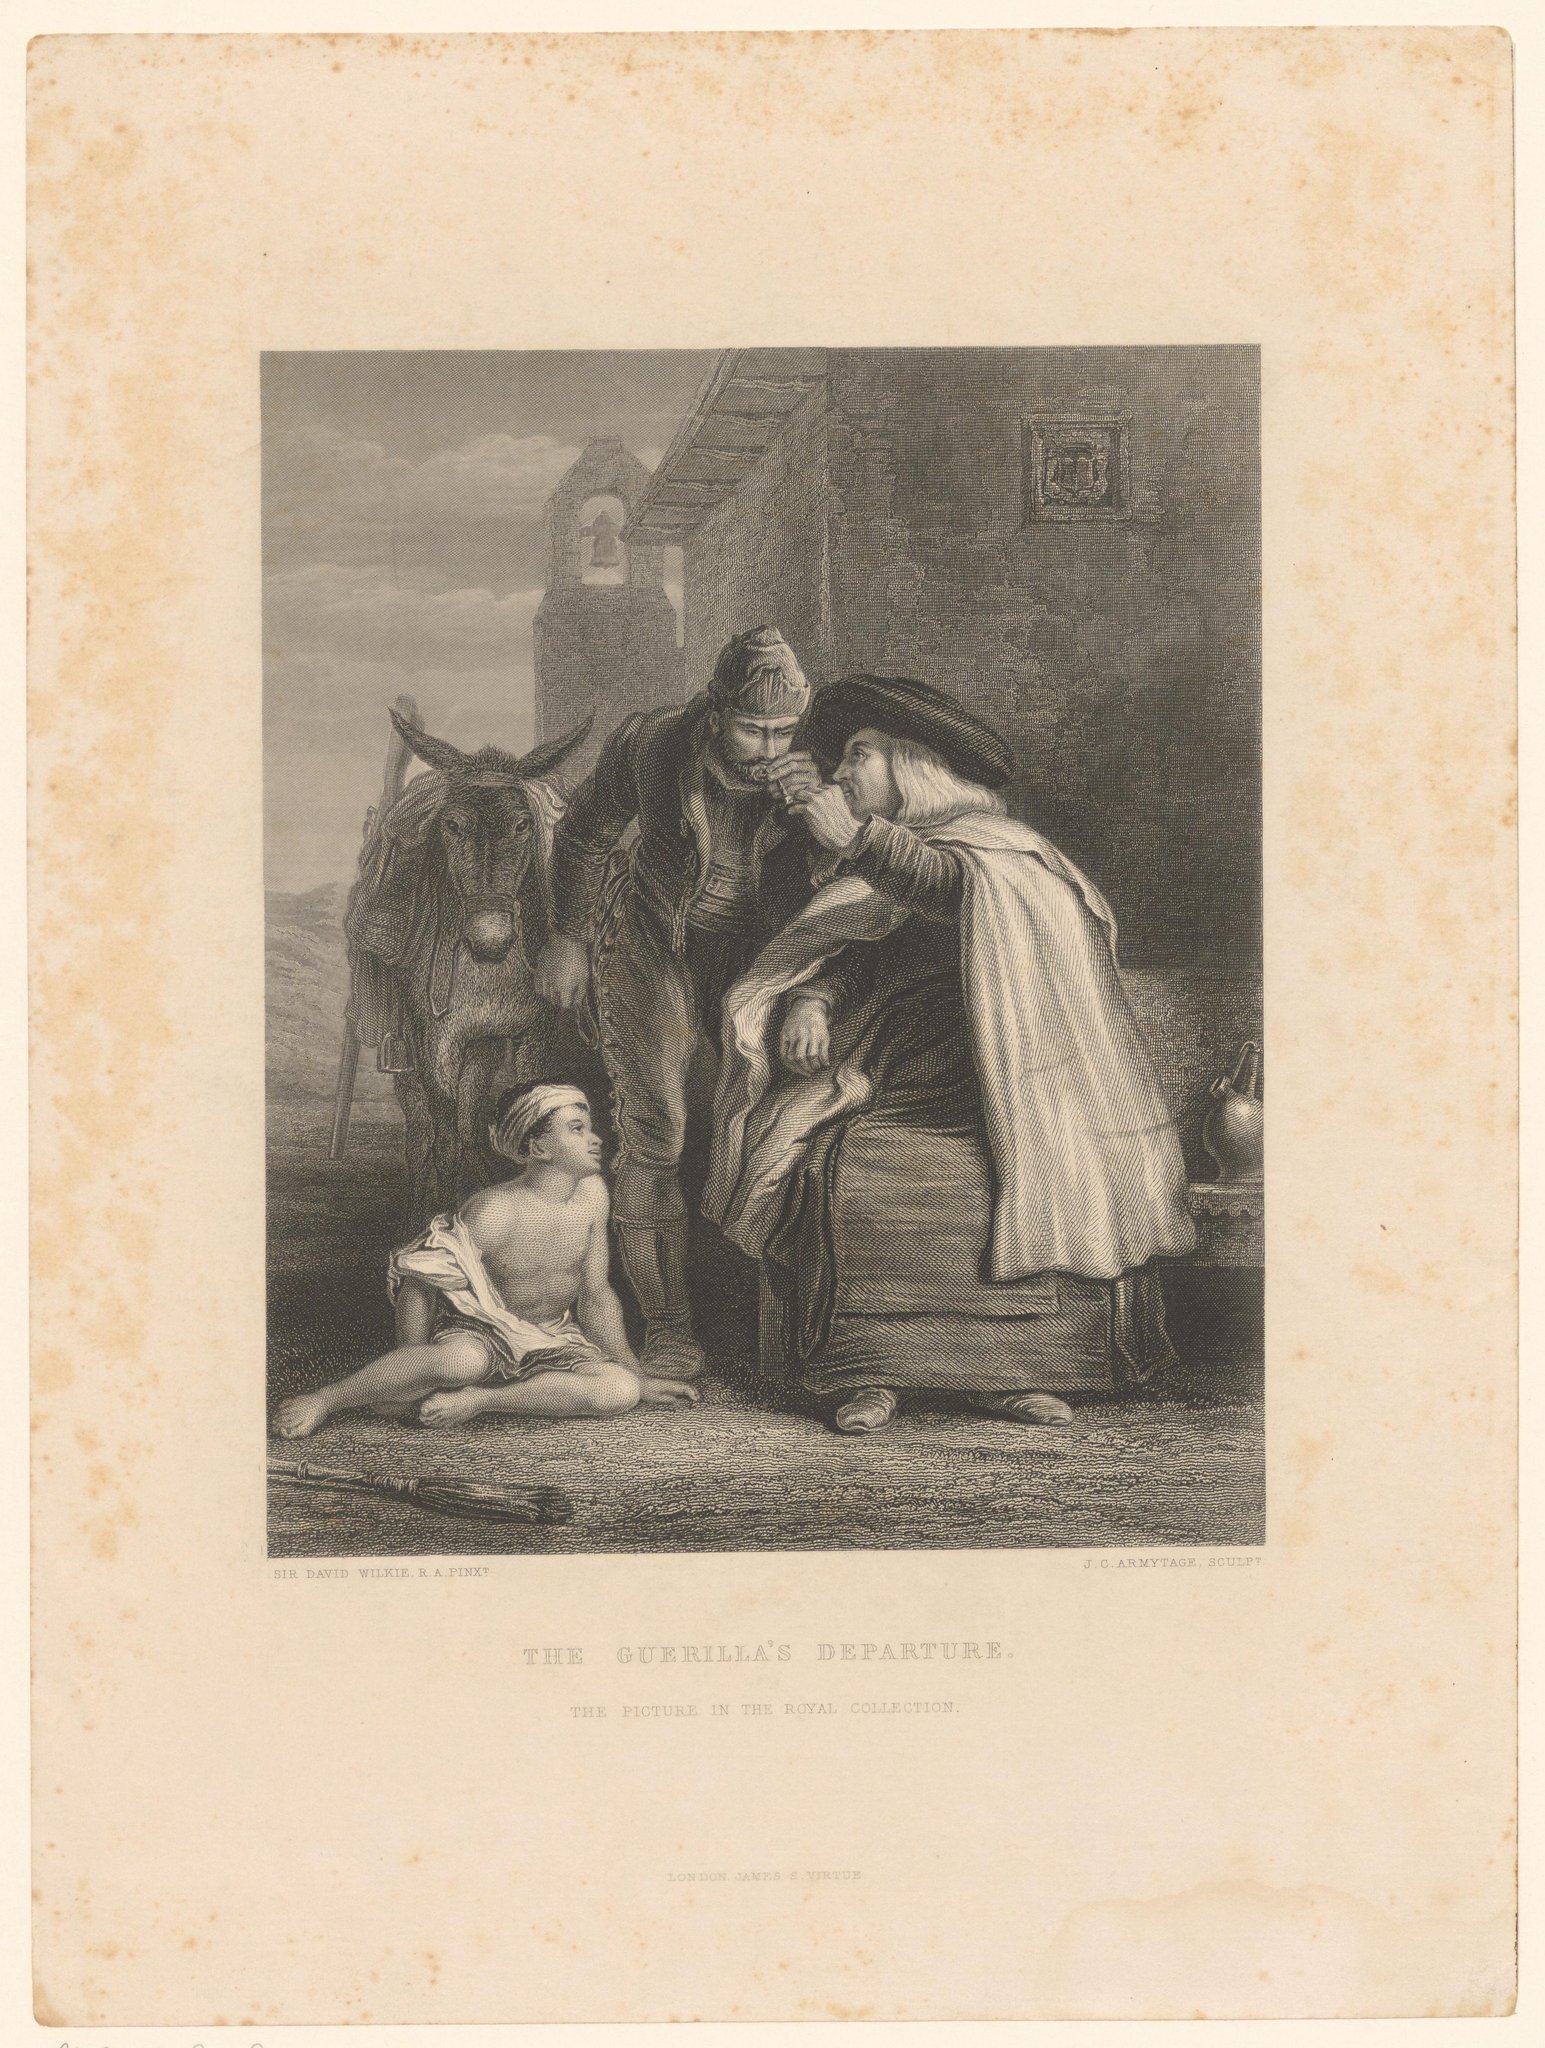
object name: print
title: Vertrek van een guerrilla tijdens de Spaanse Onafhankelijkheidsoorlog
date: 1861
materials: paper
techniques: engraving, etching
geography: england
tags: priest (roman catholic), guerilla warfare, church (exterior)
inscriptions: collector's mark: Lugt 2228